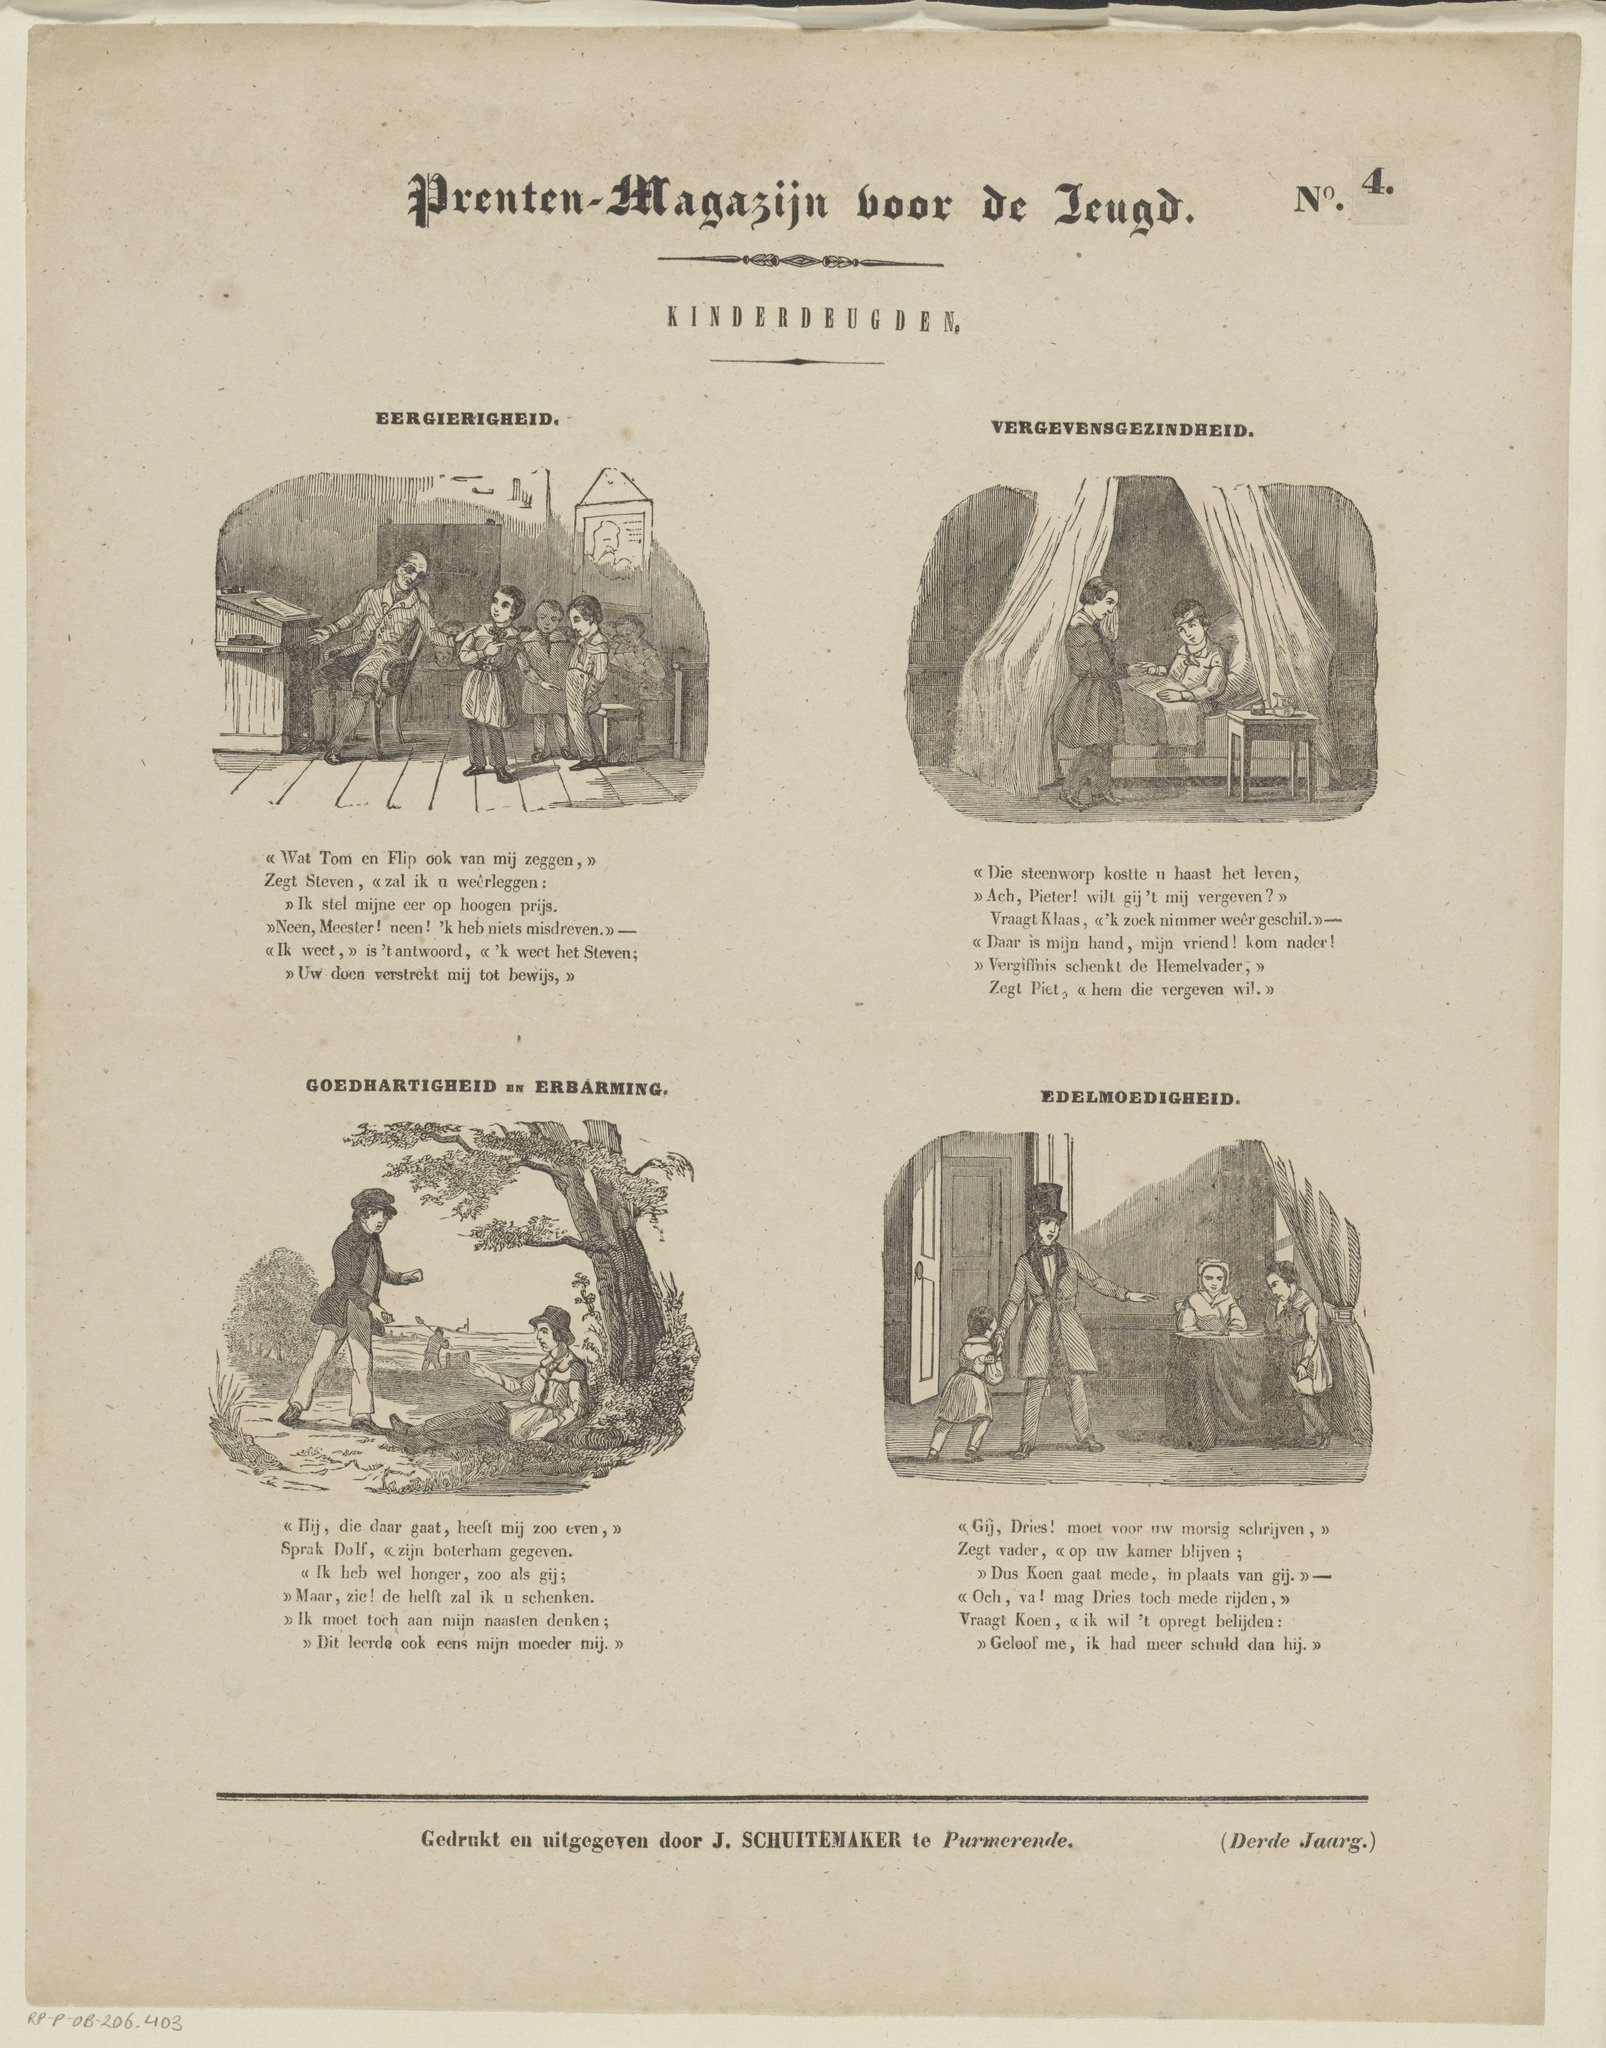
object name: popular print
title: Kinderdeugden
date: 1844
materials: paper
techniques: letterpress printing, engraving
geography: netherlands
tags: good behaviour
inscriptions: collector's mark: Lugt 2760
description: Blad met 4 voorstellingen van kinderdeugden, waaronder vergevingsgezindheid en edelmoedigheid. Boven elke voorstelling een titel en onder elke voorstelling een zesregelig vers. Genummerd rechtsboven: No. 4 (uitgeknipt en opgeplakt).